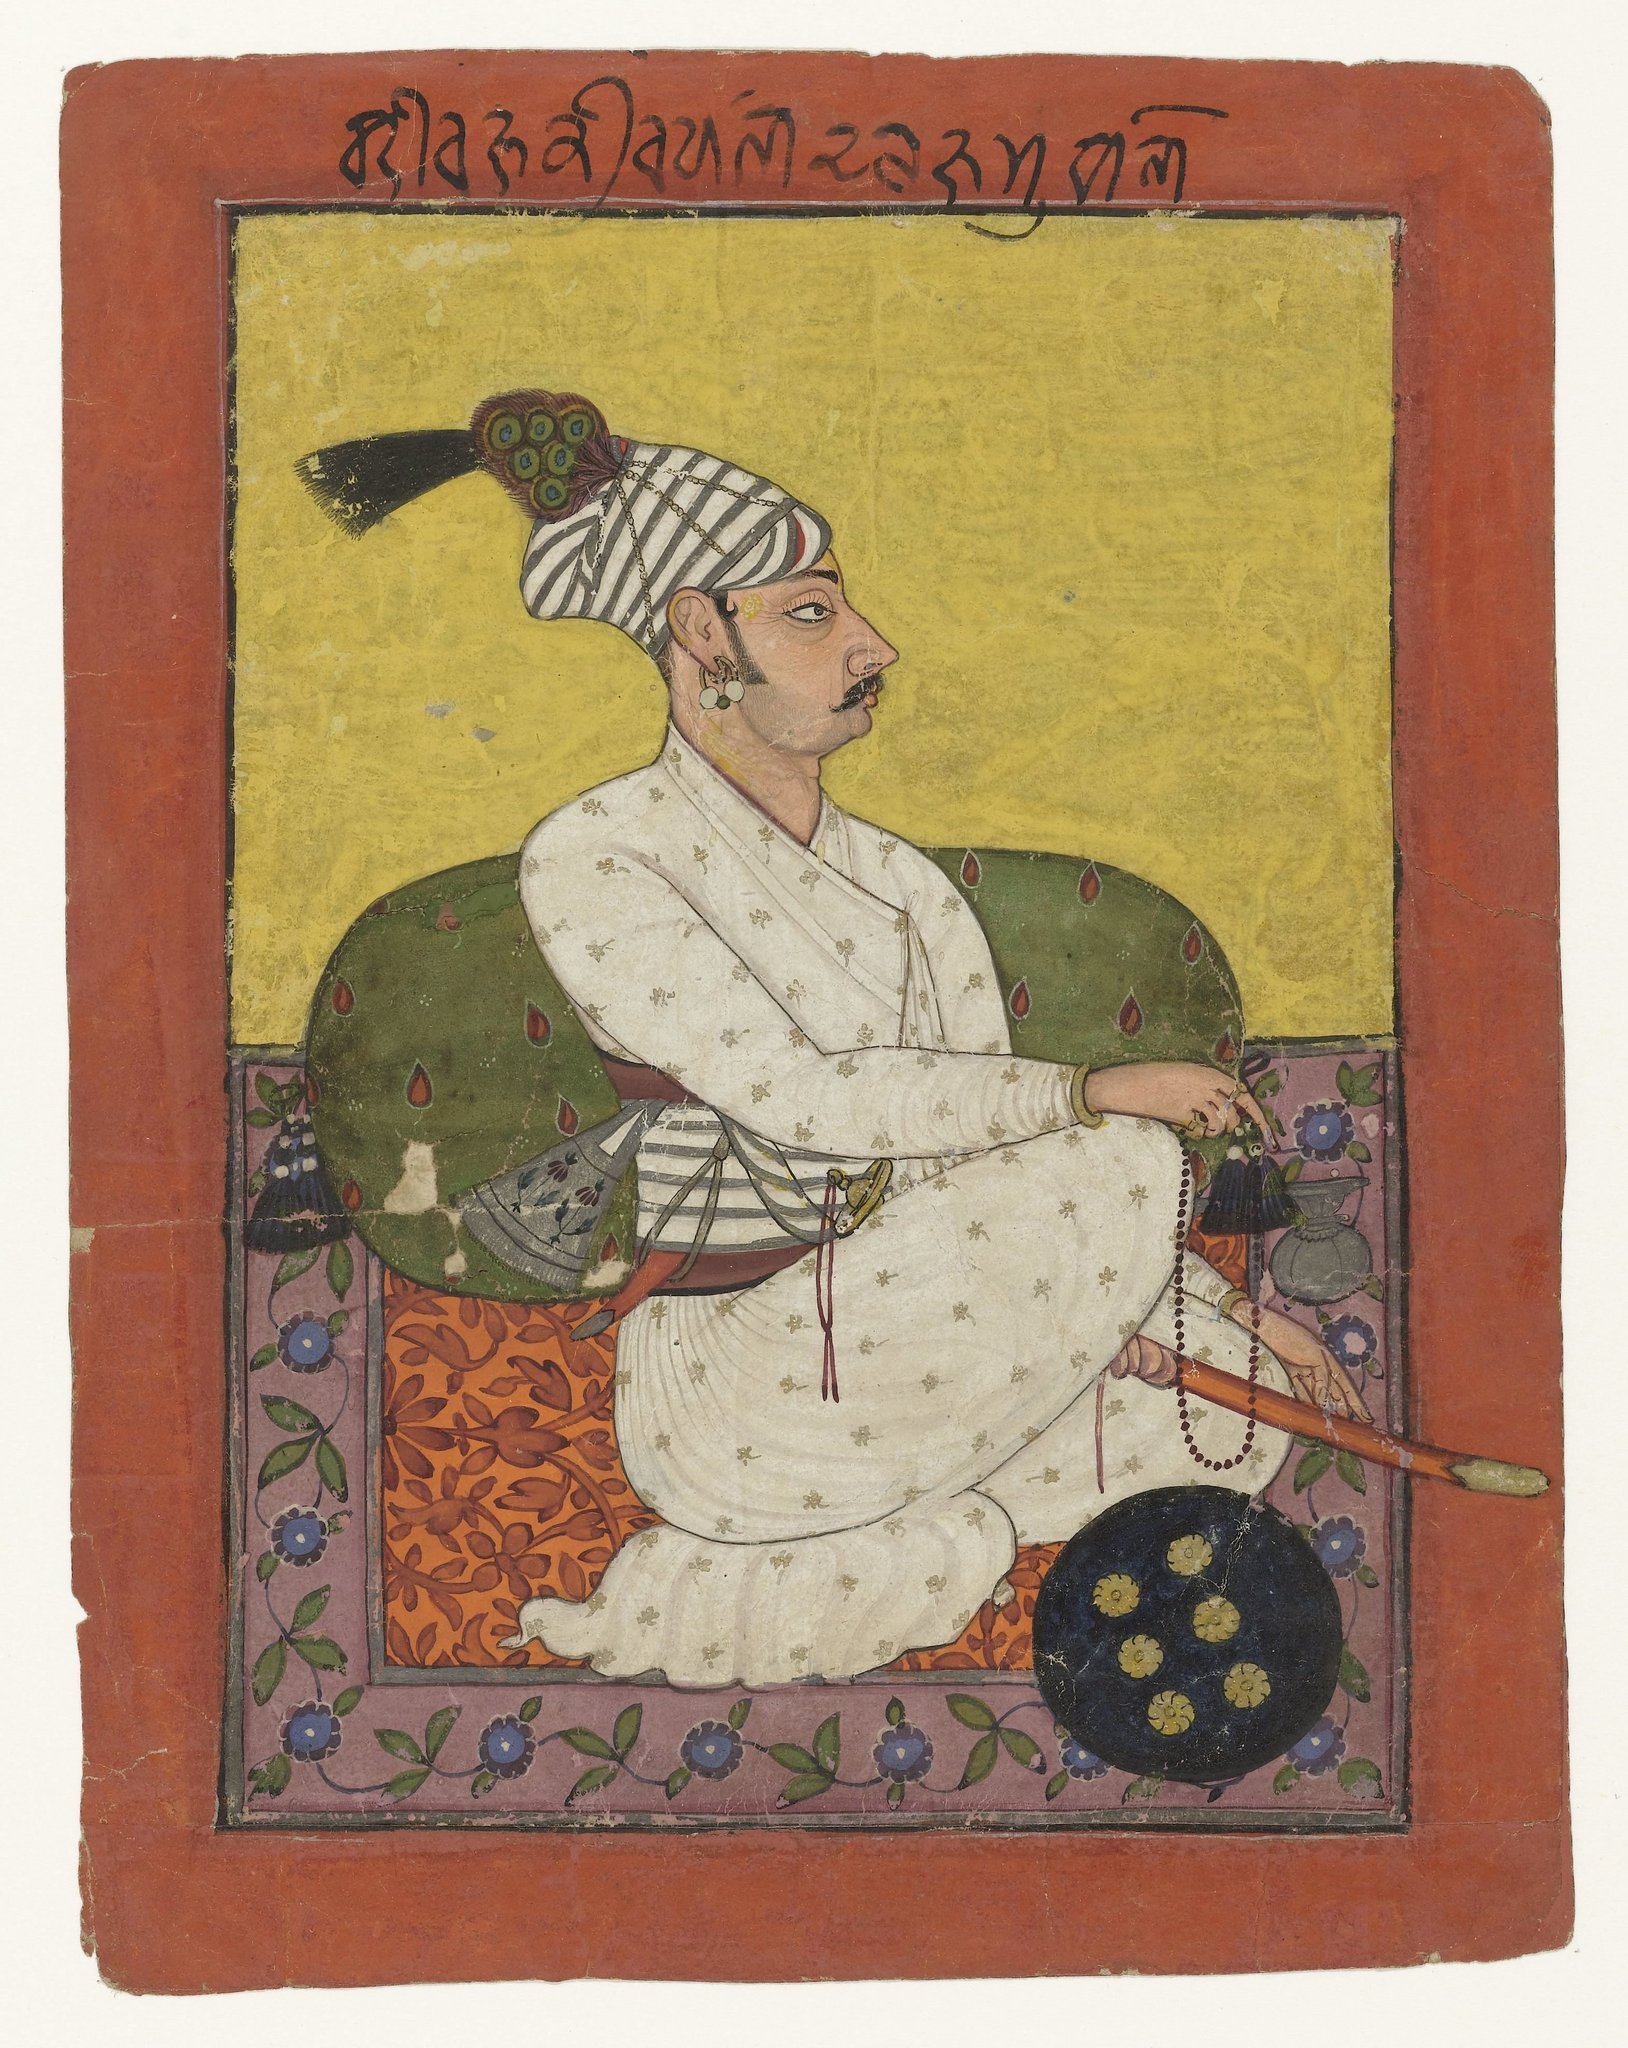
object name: indian miniature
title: Portret van Raja Kirpal Dev van Bahu (Jammu)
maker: Anonymous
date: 1655-1685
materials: gouache, paper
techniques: brush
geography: mankot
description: Portret van Raja Kirpal Dev (1660-1690) van Bahu (Jammu).